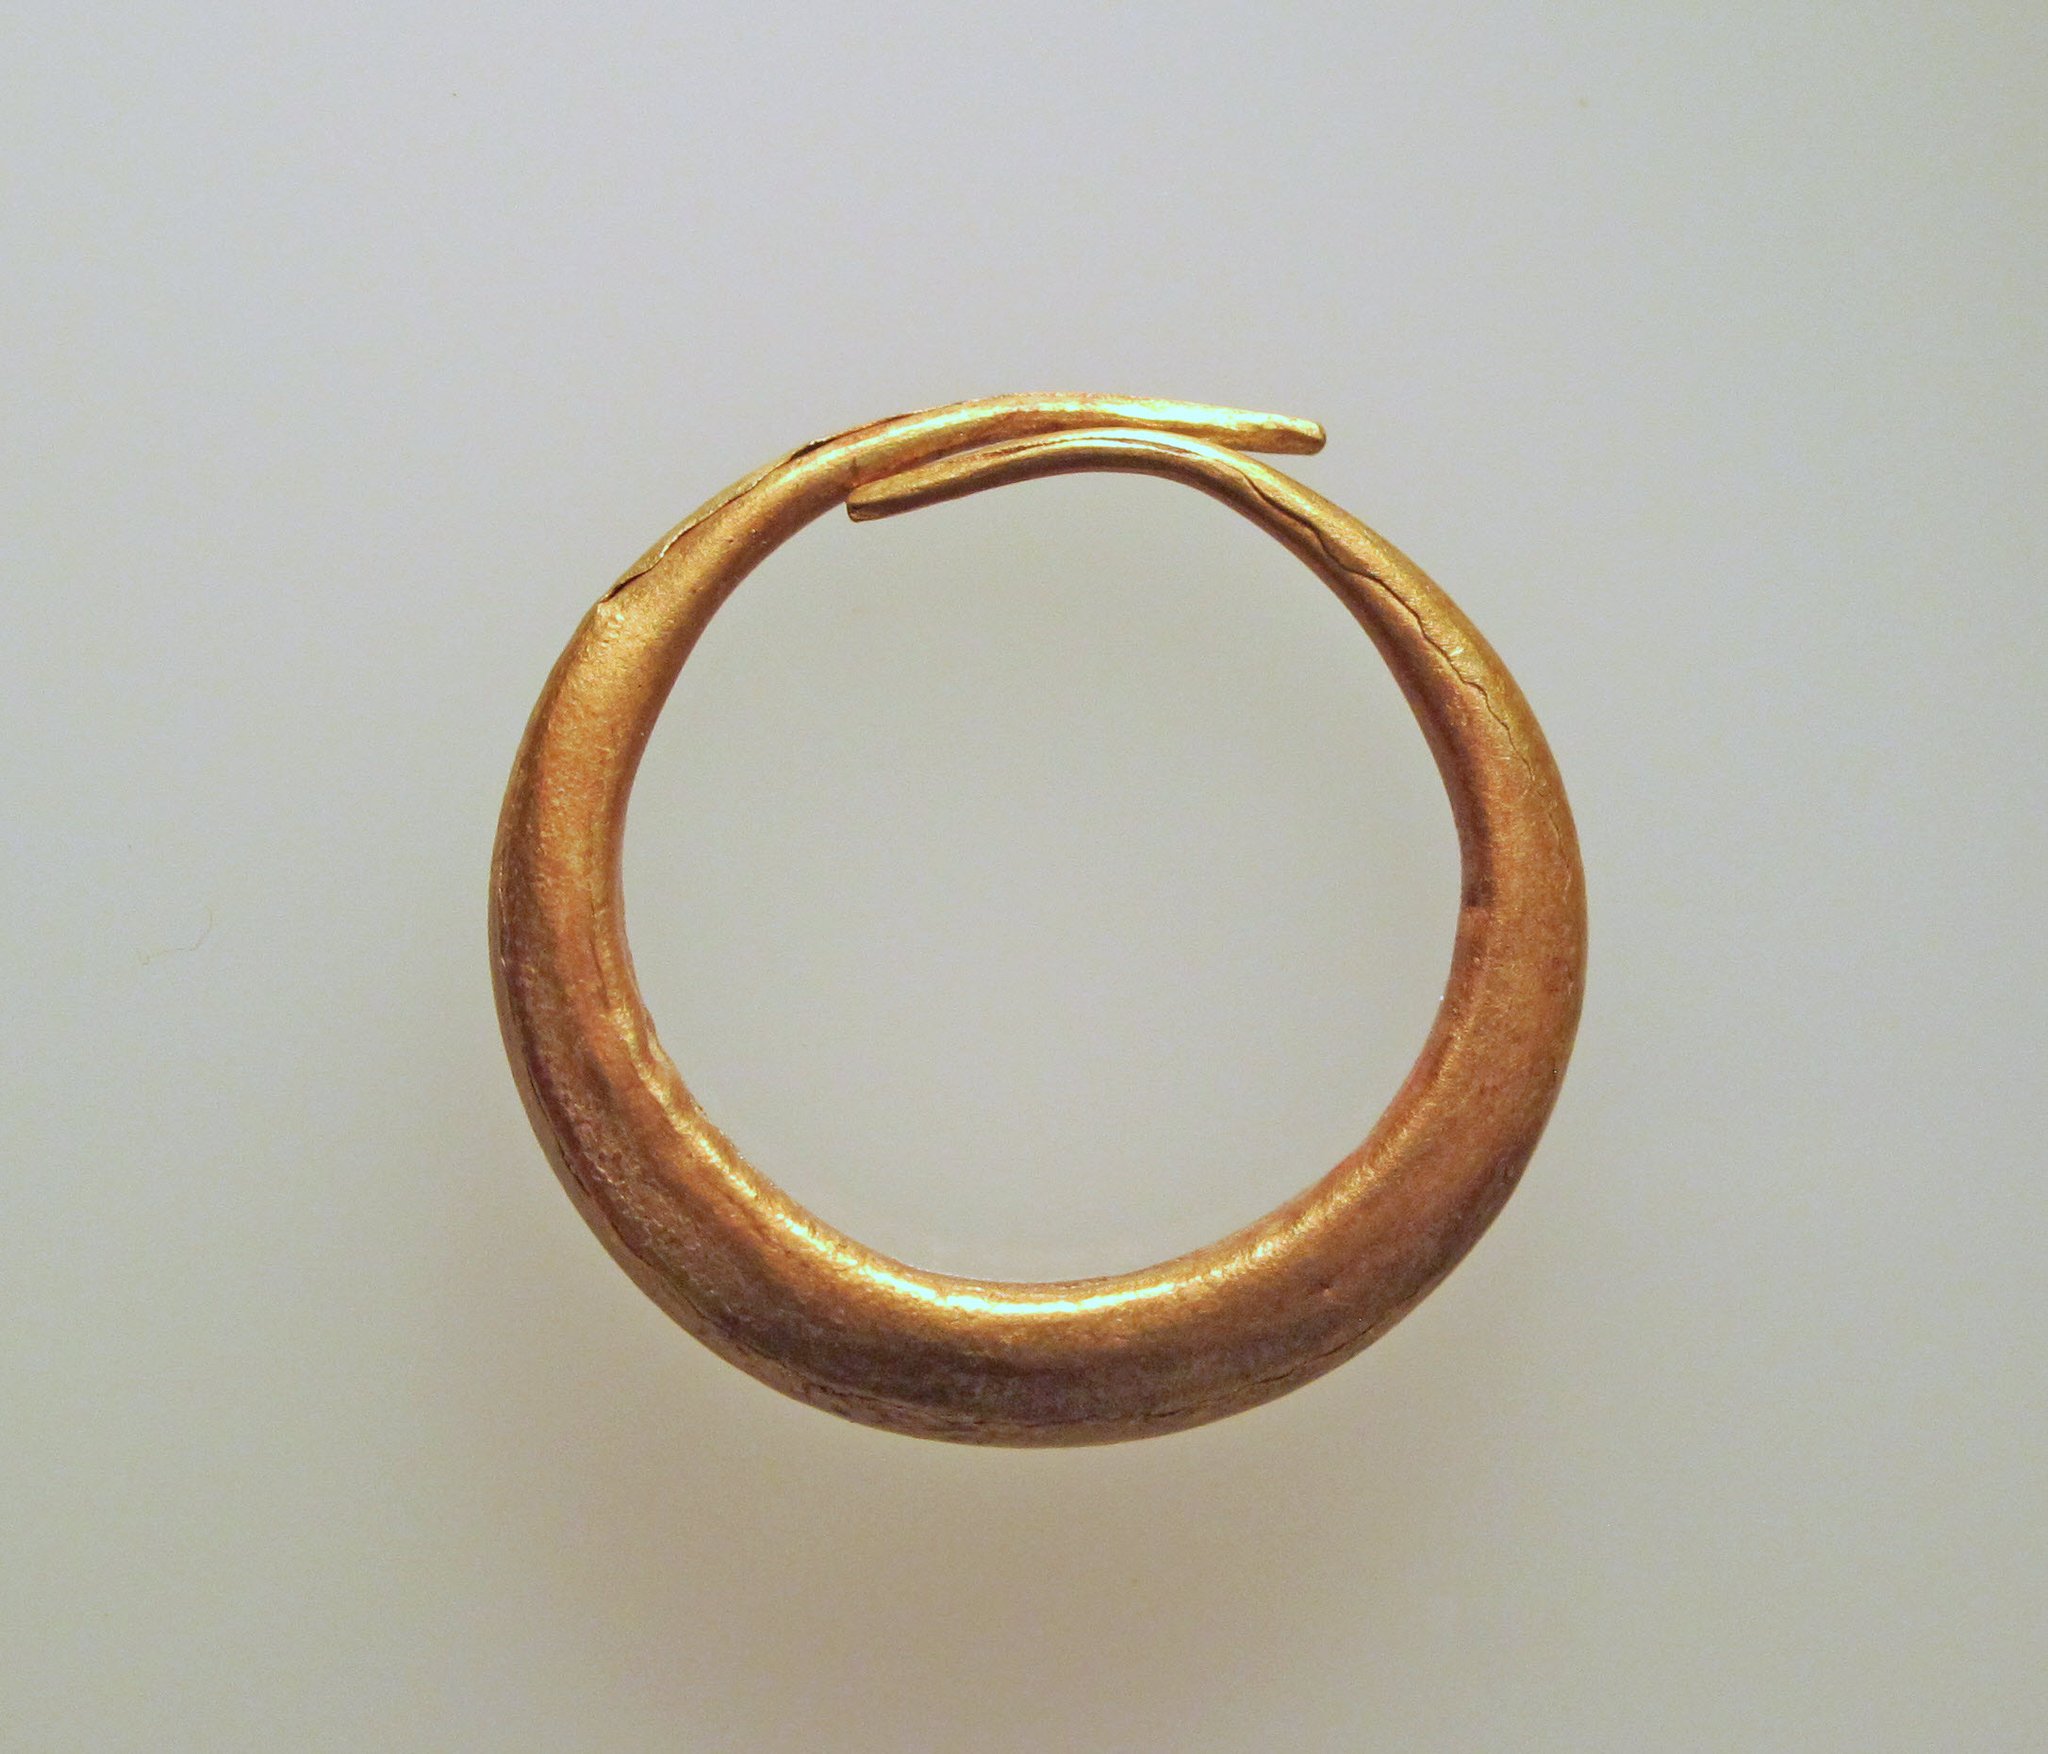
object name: earring of simple form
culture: cypriot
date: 3900 BCE-100 CE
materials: gold